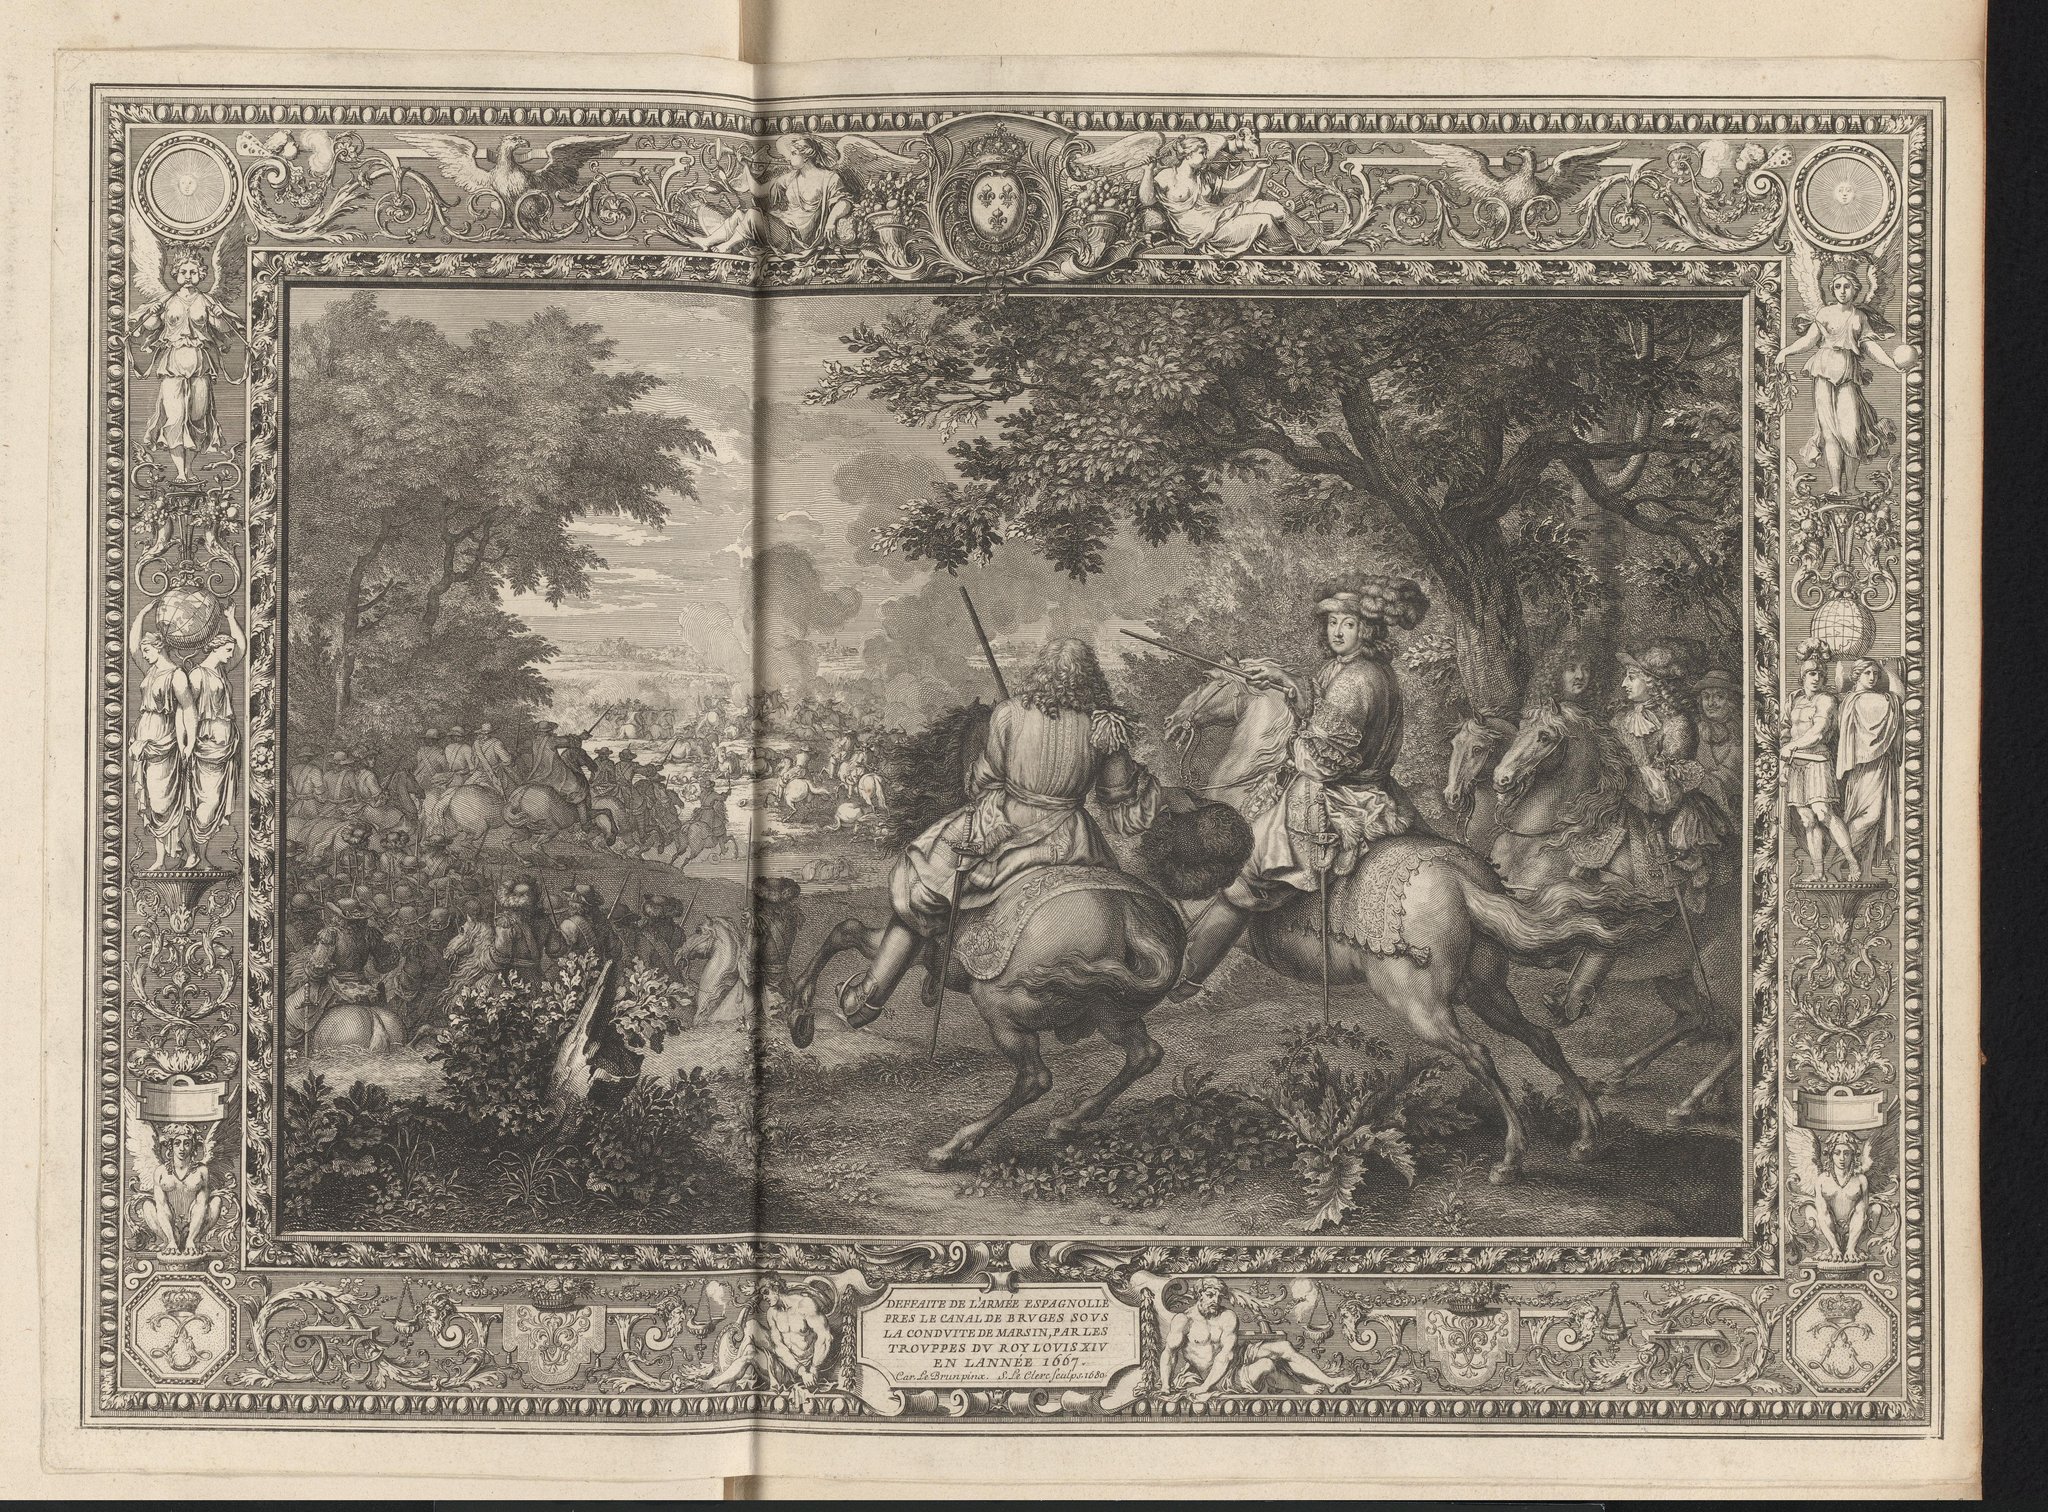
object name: print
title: Deffaite de l'armée Espagnolle/ pres le canal de Bruges (...)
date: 1689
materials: paper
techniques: engraving, etching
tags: lodewijk xiv (koning van frankrijk), historical persons, war, king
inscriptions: date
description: Veldslag met op de voorgrond koning Lodewijk XIV te paard. Prent maakt deel uit van een album.